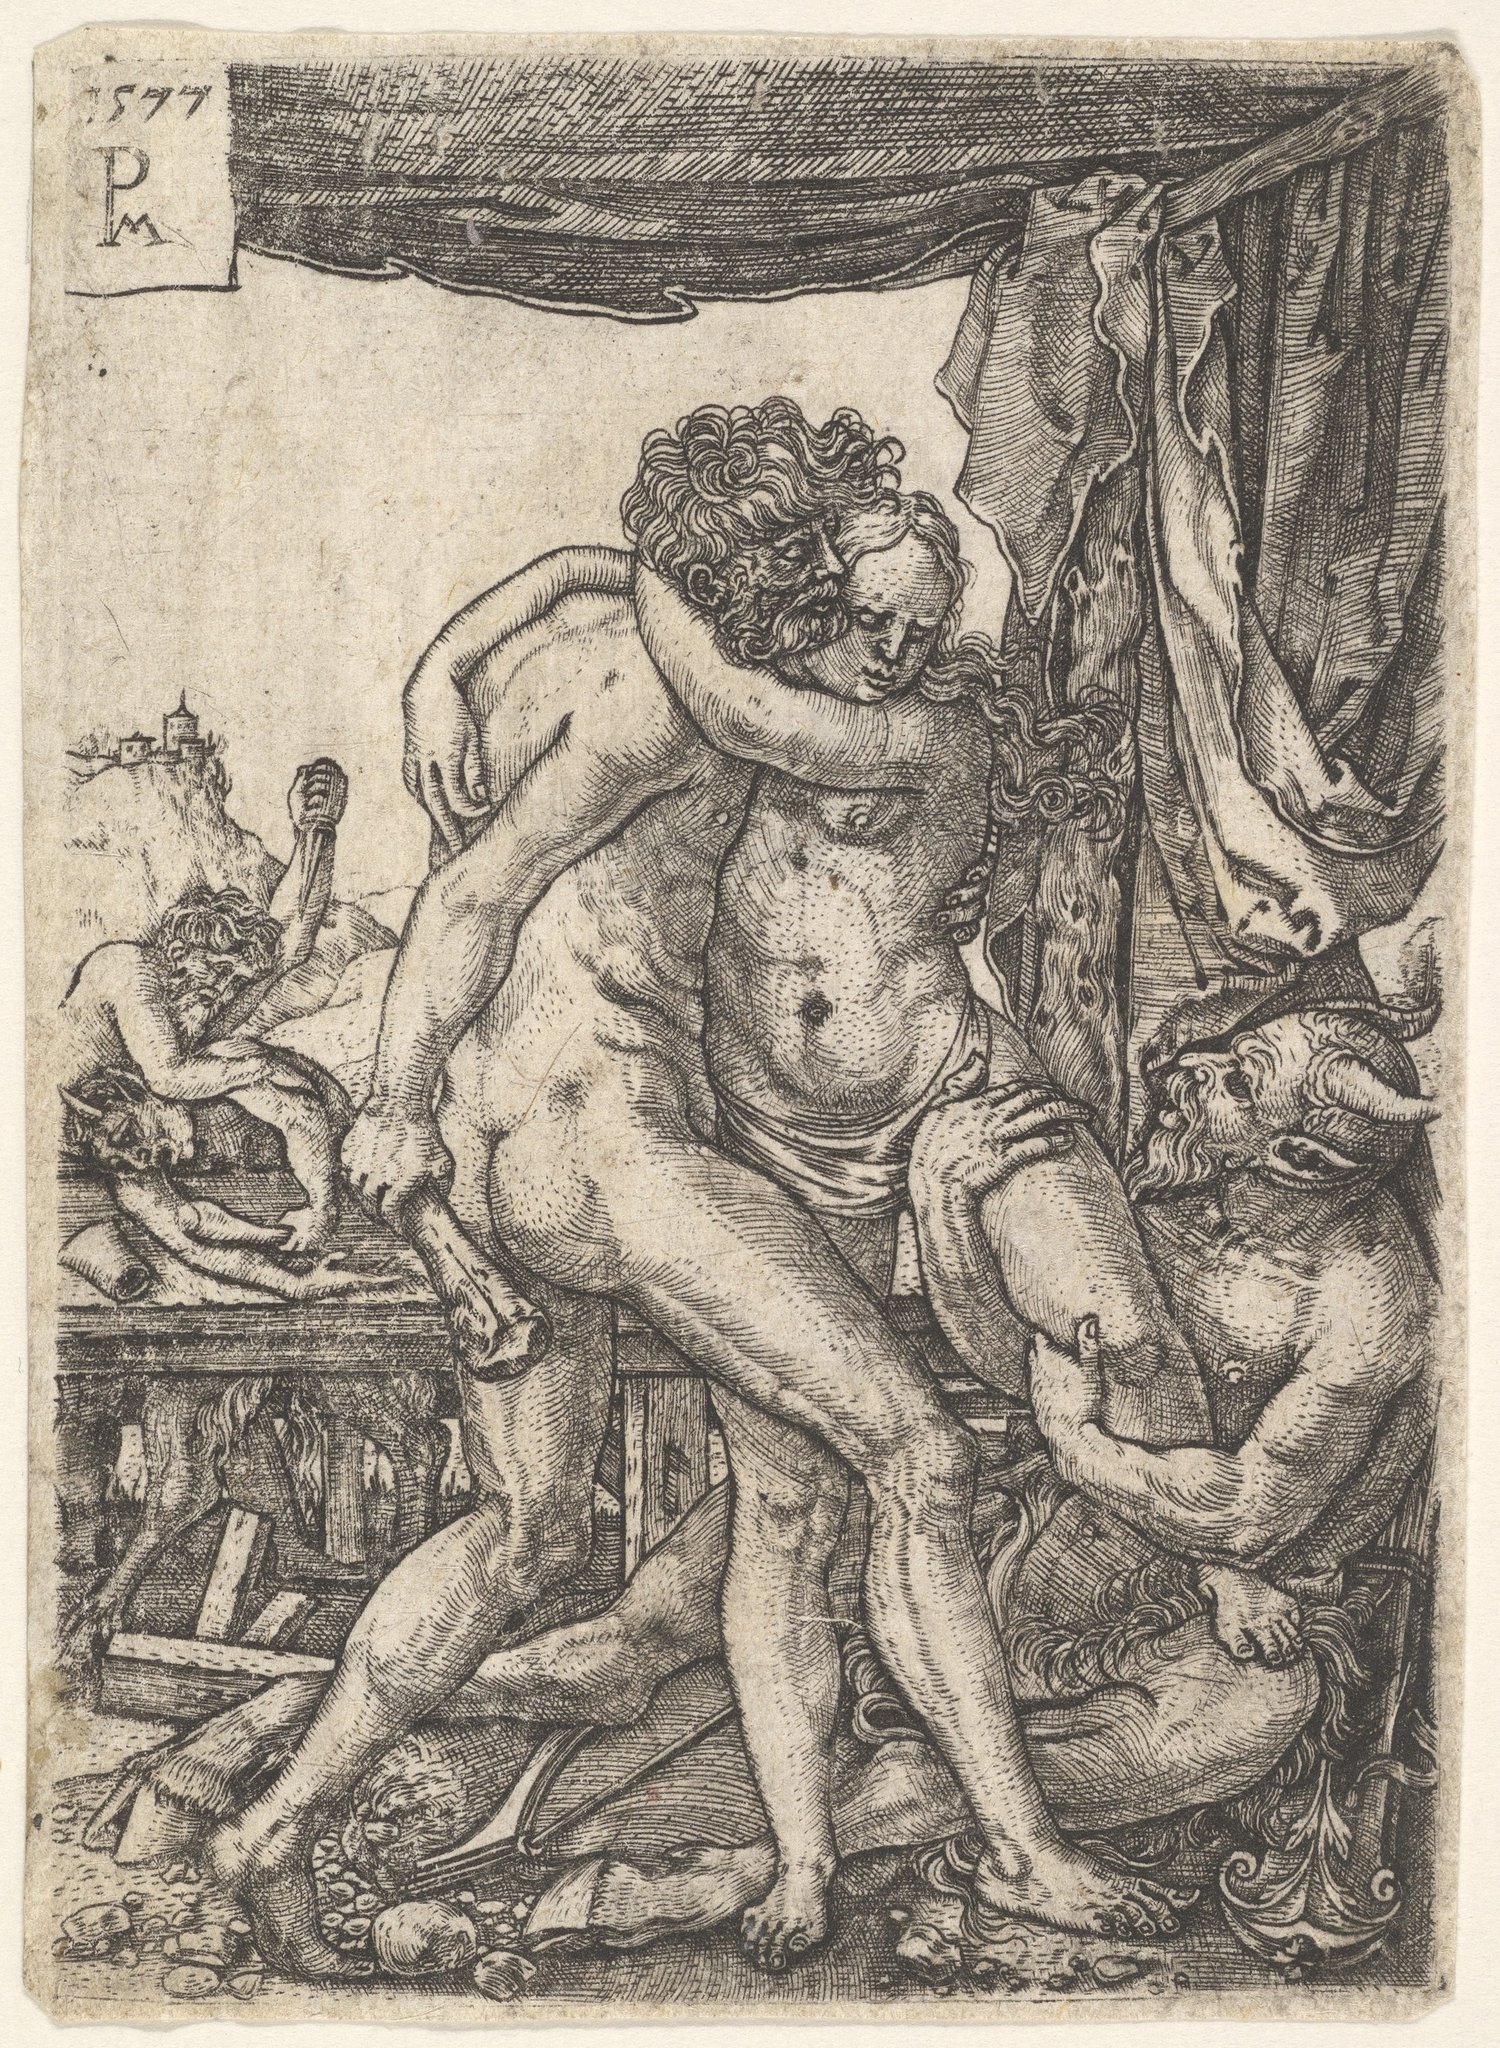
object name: print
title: Hercules Fighting the Centaurs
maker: master pm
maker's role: artist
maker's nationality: german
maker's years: 1550-1600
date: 1577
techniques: engraving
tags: female nudes,hercules,centaurs